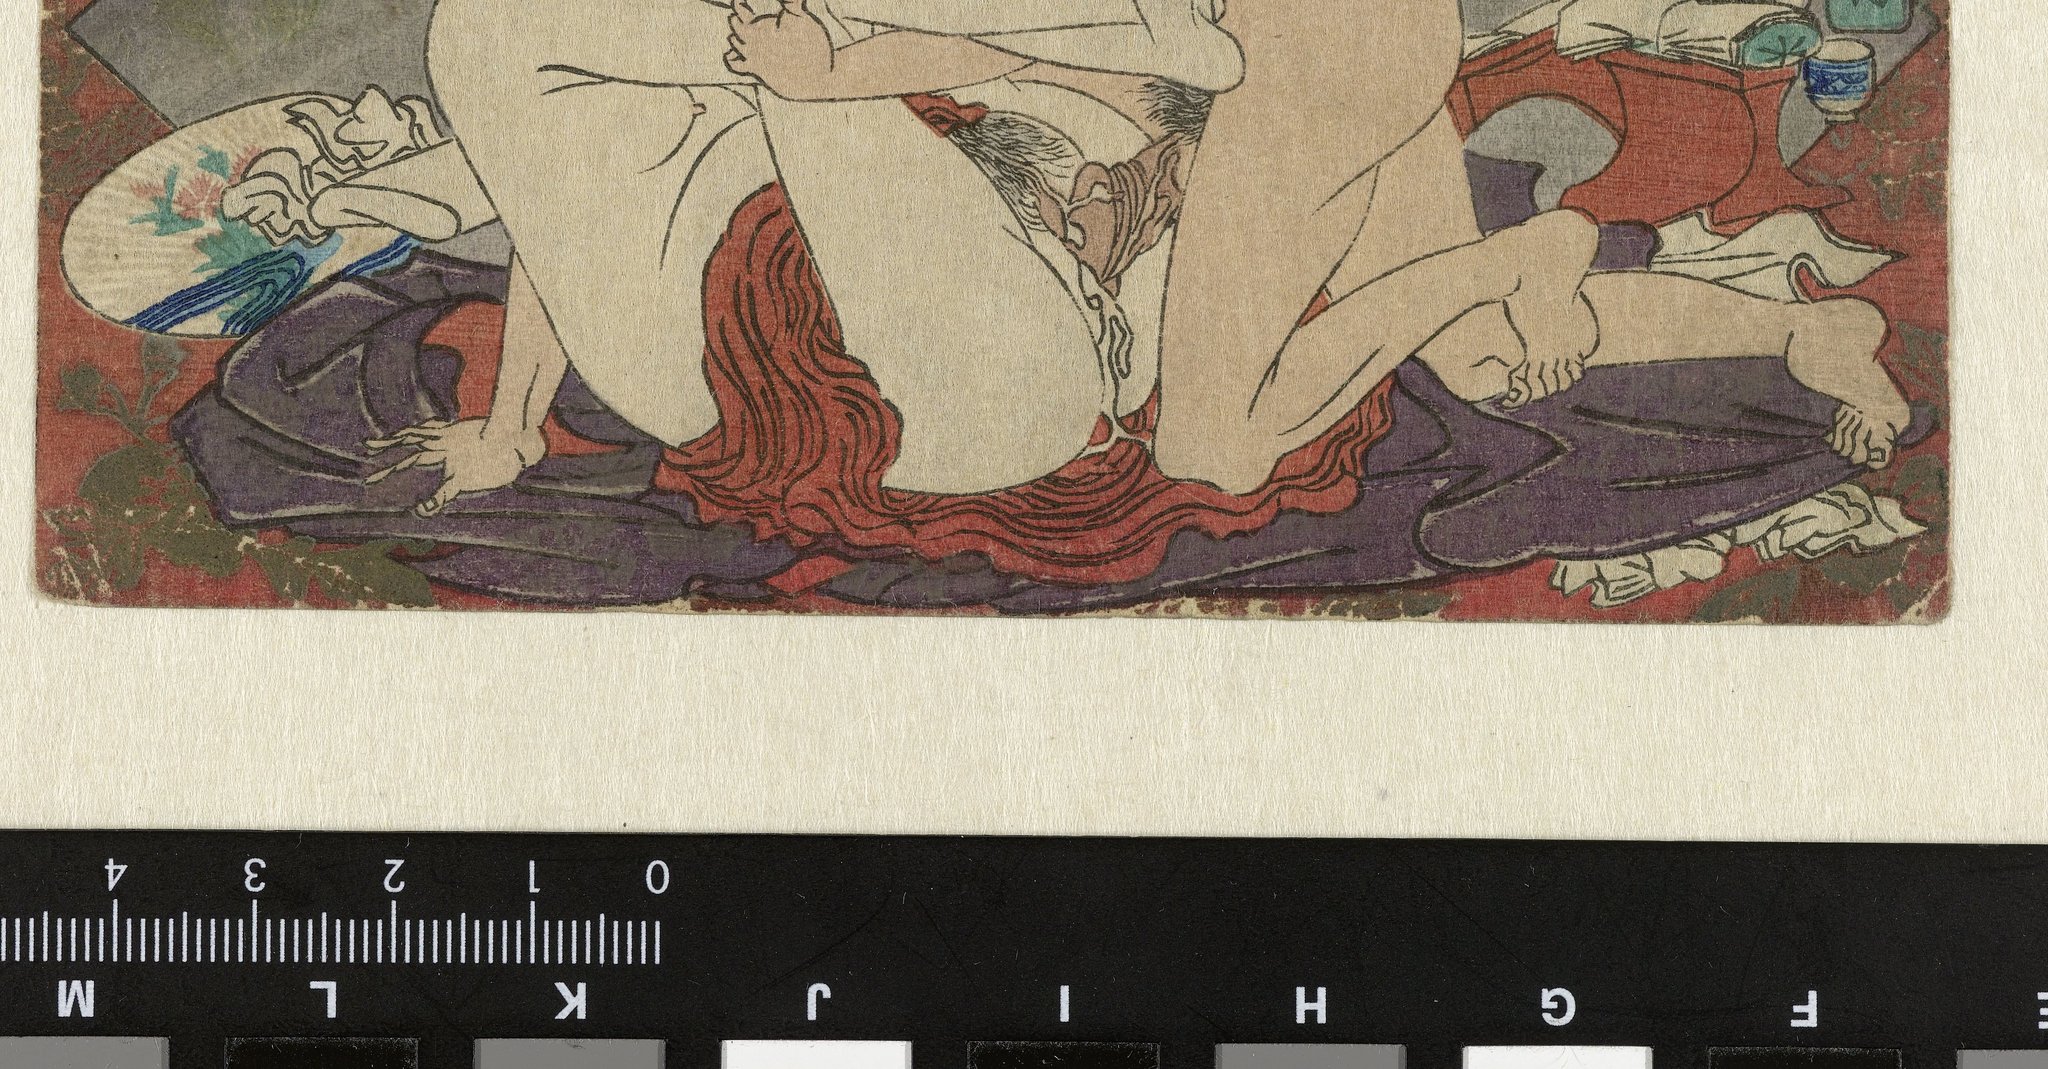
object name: print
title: Irome ôgi, de 'amoureuze waaier'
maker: Anonymous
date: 1850-1860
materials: paper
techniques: woodcut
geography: japan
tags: fan, tea-pot; samovar, coitus, cohabiting, sexual intercourse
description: Een liefdespaar in omhelzing. De man trekt zijn lid terug. Naast hen theegerei en een waaier. Achter hen een paarse waaier.